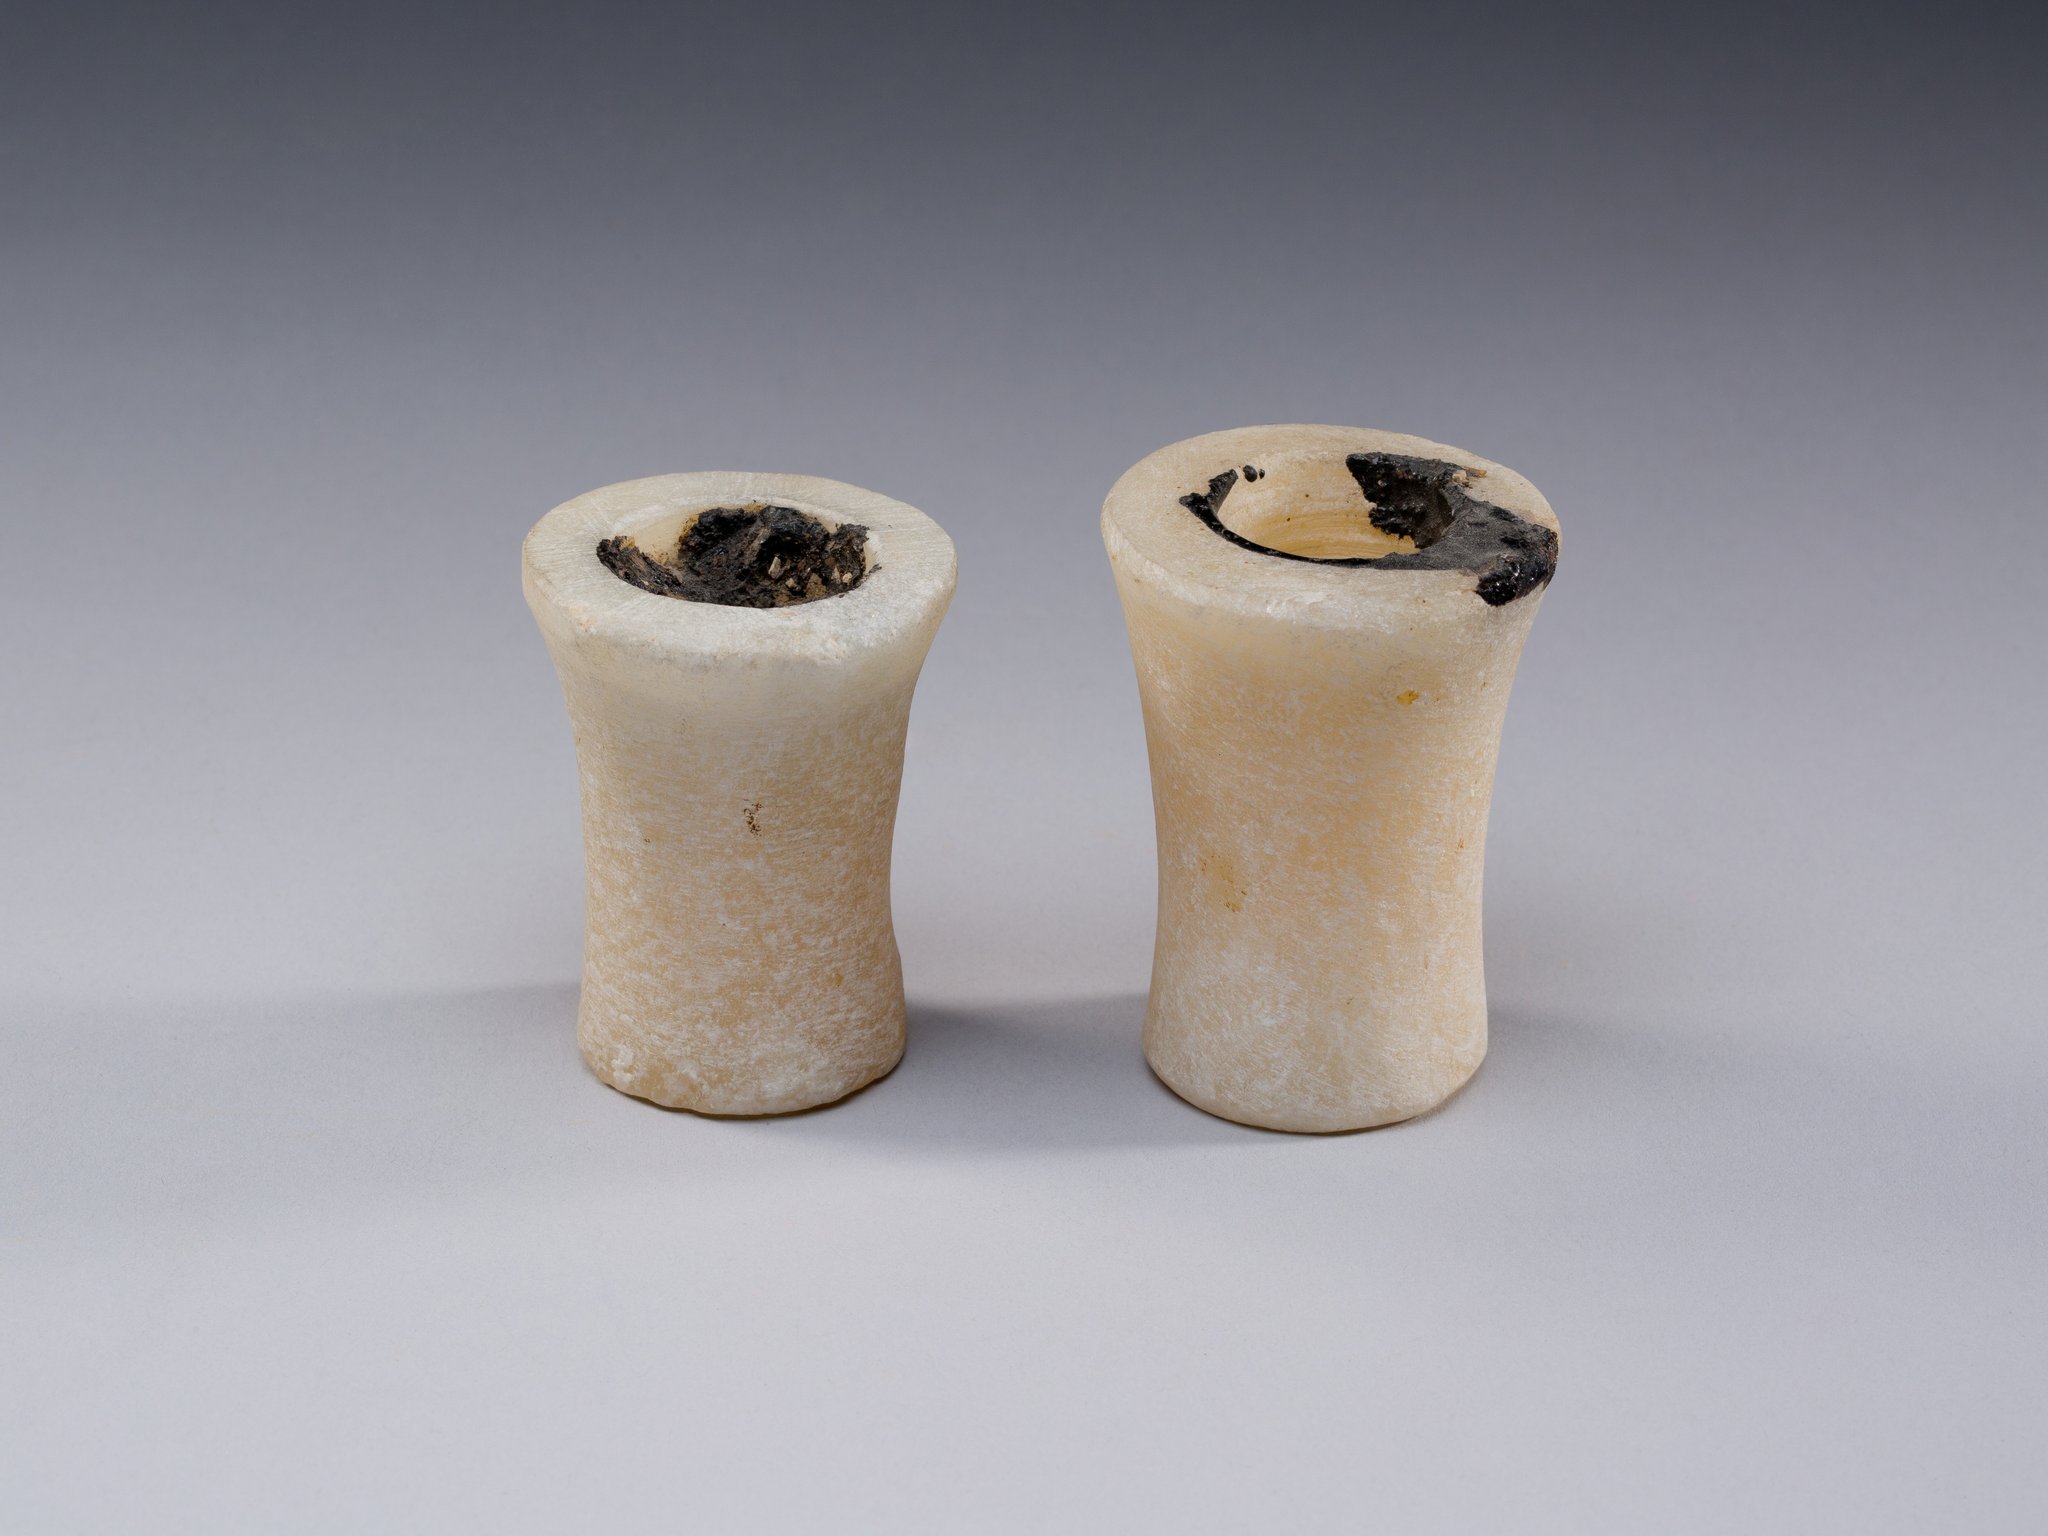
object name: ointment jar, model, senenmut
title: Model Ointment Jar from a Foundation Deposit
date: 1479-1458 BCE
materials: stone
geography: egypt